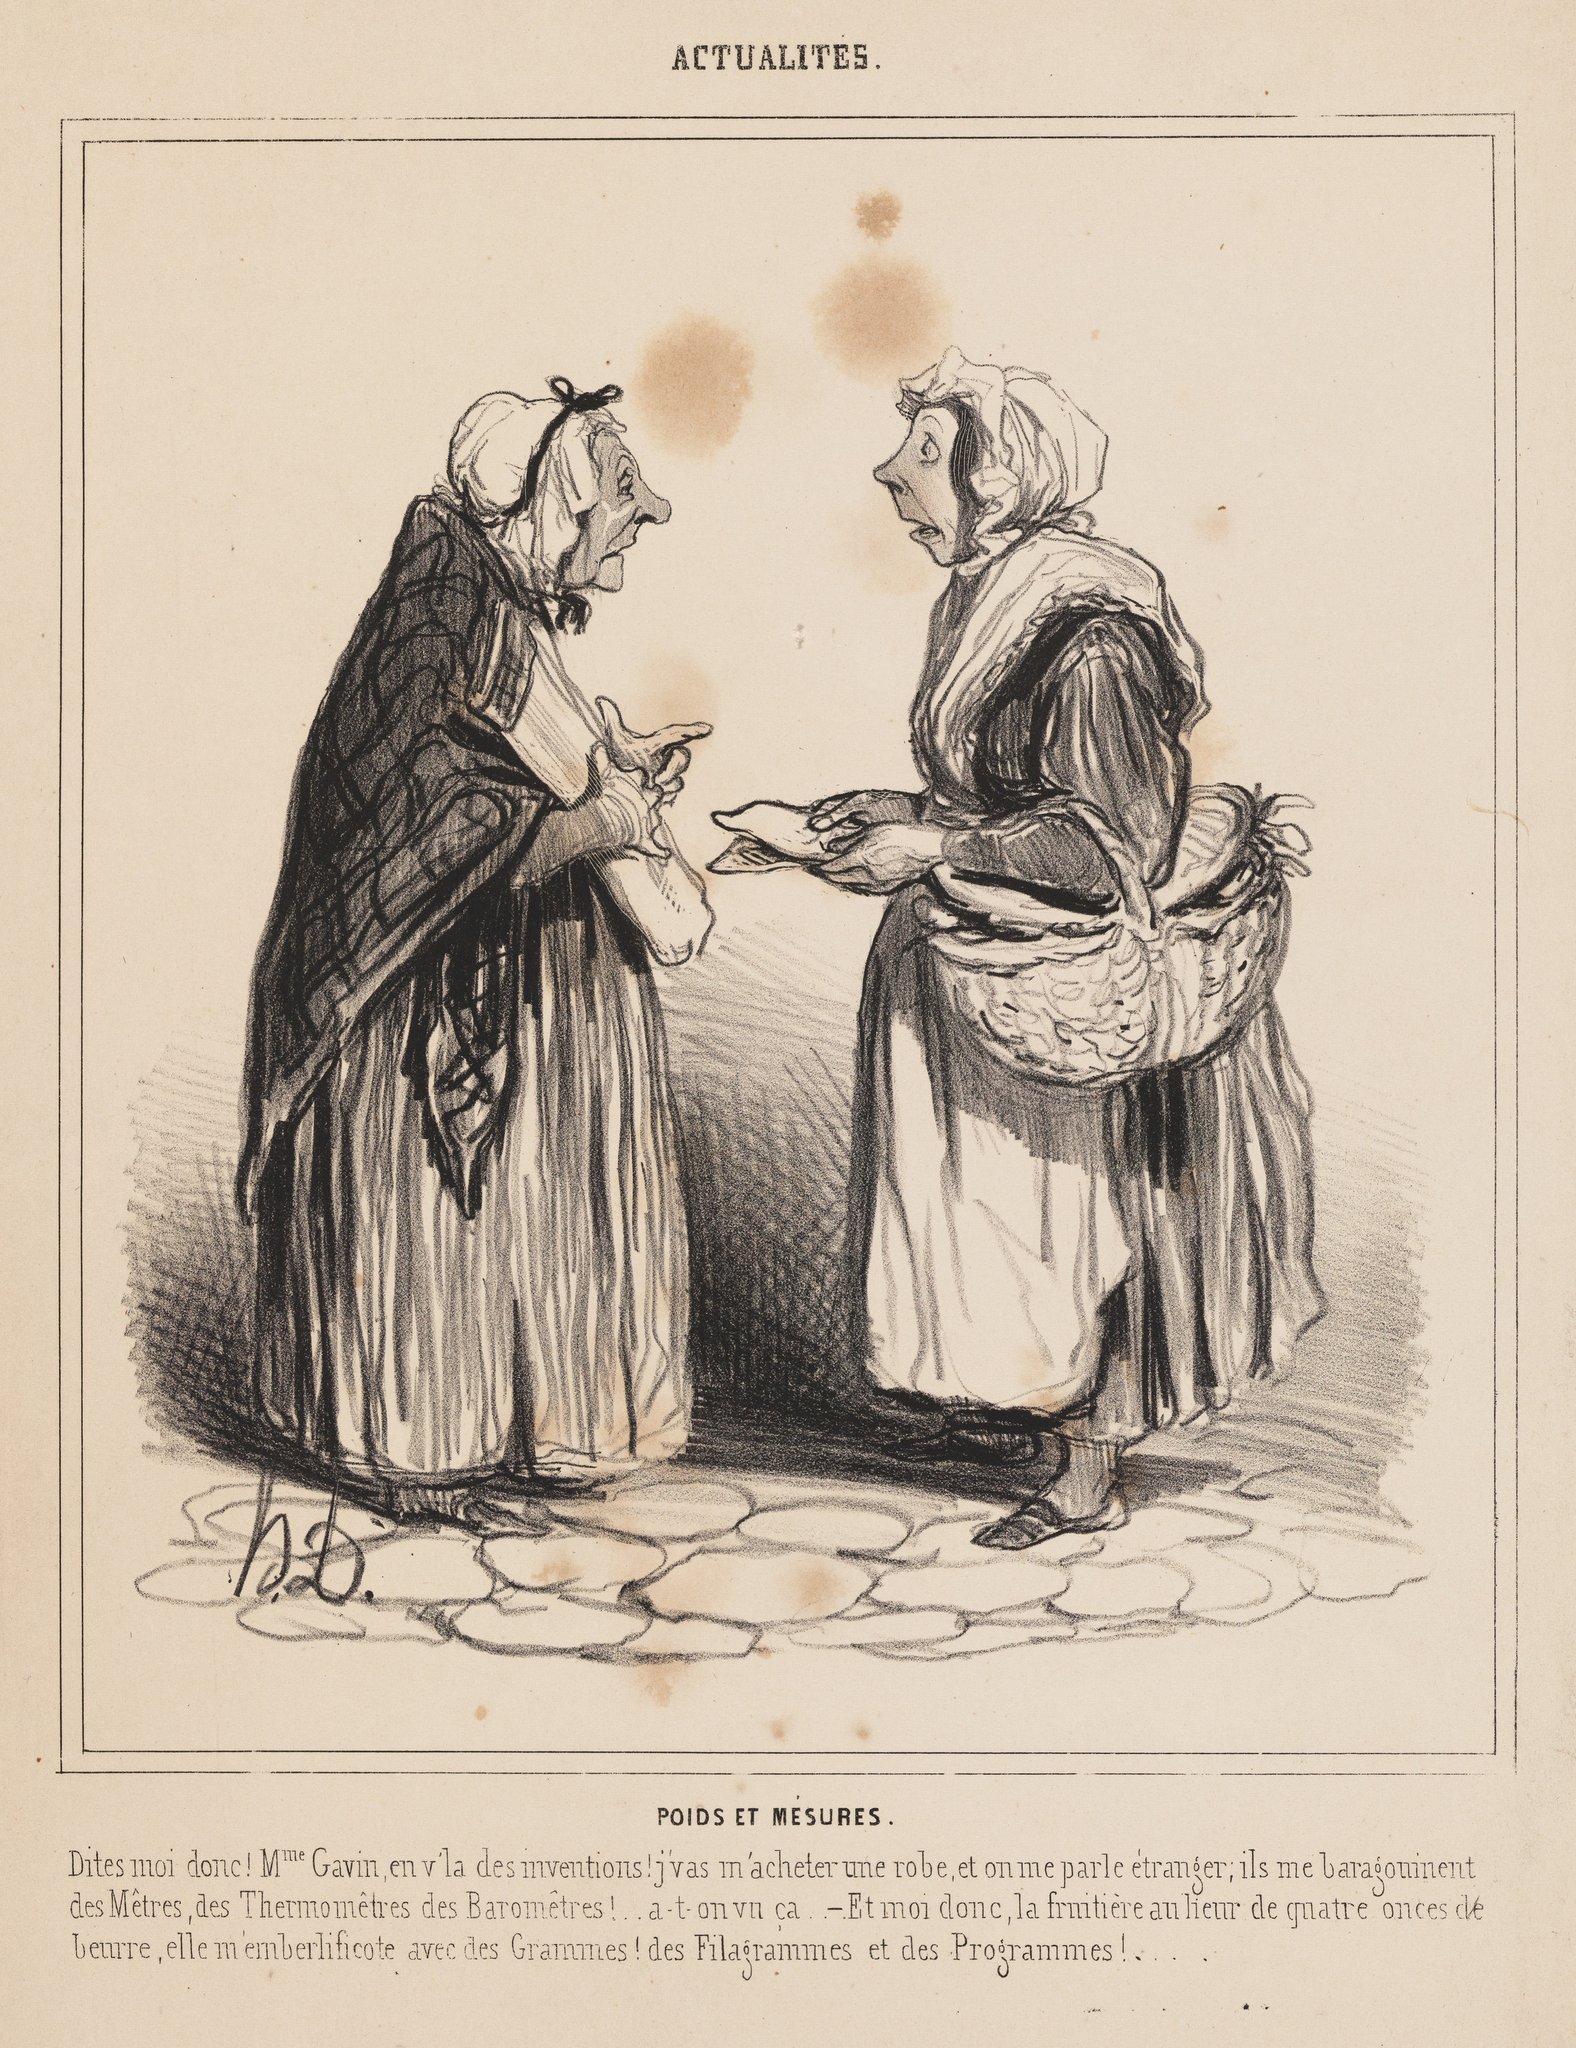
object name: print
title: Poids et mesures, from "Actualités"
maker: honoré daumier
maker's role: artist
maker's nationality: french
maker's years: 1808-1879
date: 1840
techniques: lithograph